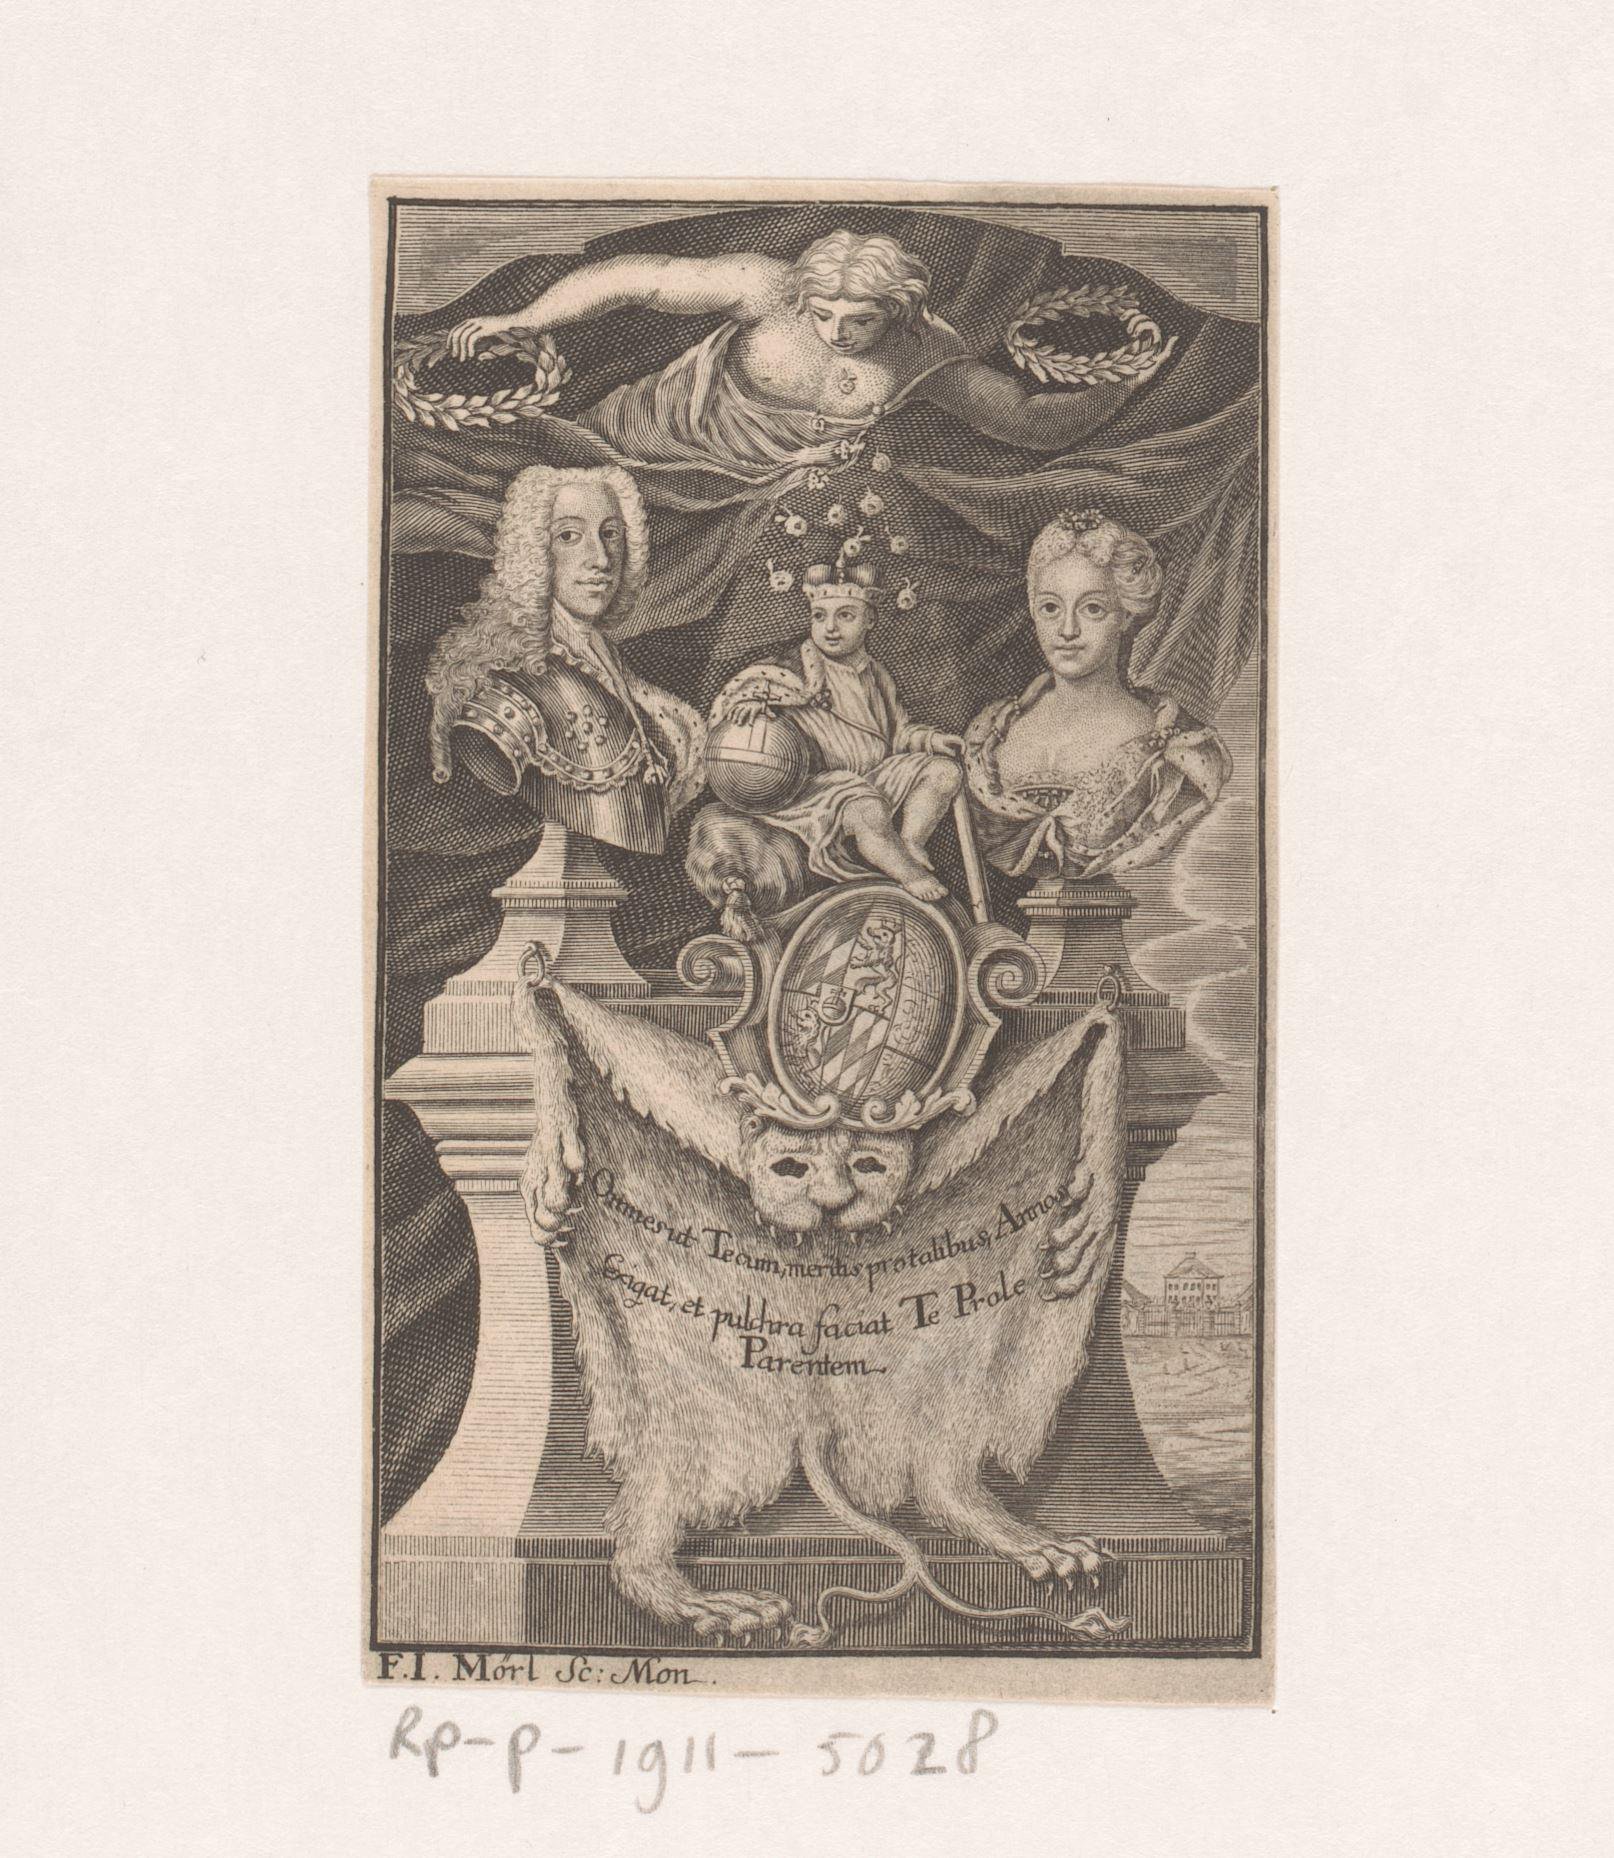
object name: print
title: Portret van keizer Karl VII Albrecht en Maria Amalia van Oostenrijk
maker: joseph mörl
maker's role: print maker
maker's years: -1735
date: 1722-1735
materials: paper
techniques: engraving, etching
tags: vienna, brussels, karel vii albrecht (duits keizer), attributes of hercules (with name), historical persons - bb - woman, historical persons, palace, wig, armorial bearing, heraldry, insignia and symbols of sovereignty (crown, diadem, sceptre, orb, seal, standard, cloak, pectoral)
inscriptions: collector's mark: Lugt 2228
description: Tussen de twee bustes van de geportretteerden zit een kind met symbolen van soevereiniteit. Het familiewapen staat onder het kind en een leeuwenhuid waarop tekst. Beide bustes krijgen erboven een lauwerkrans gehouden. In de achtergrond het paleis Nymphenburg.